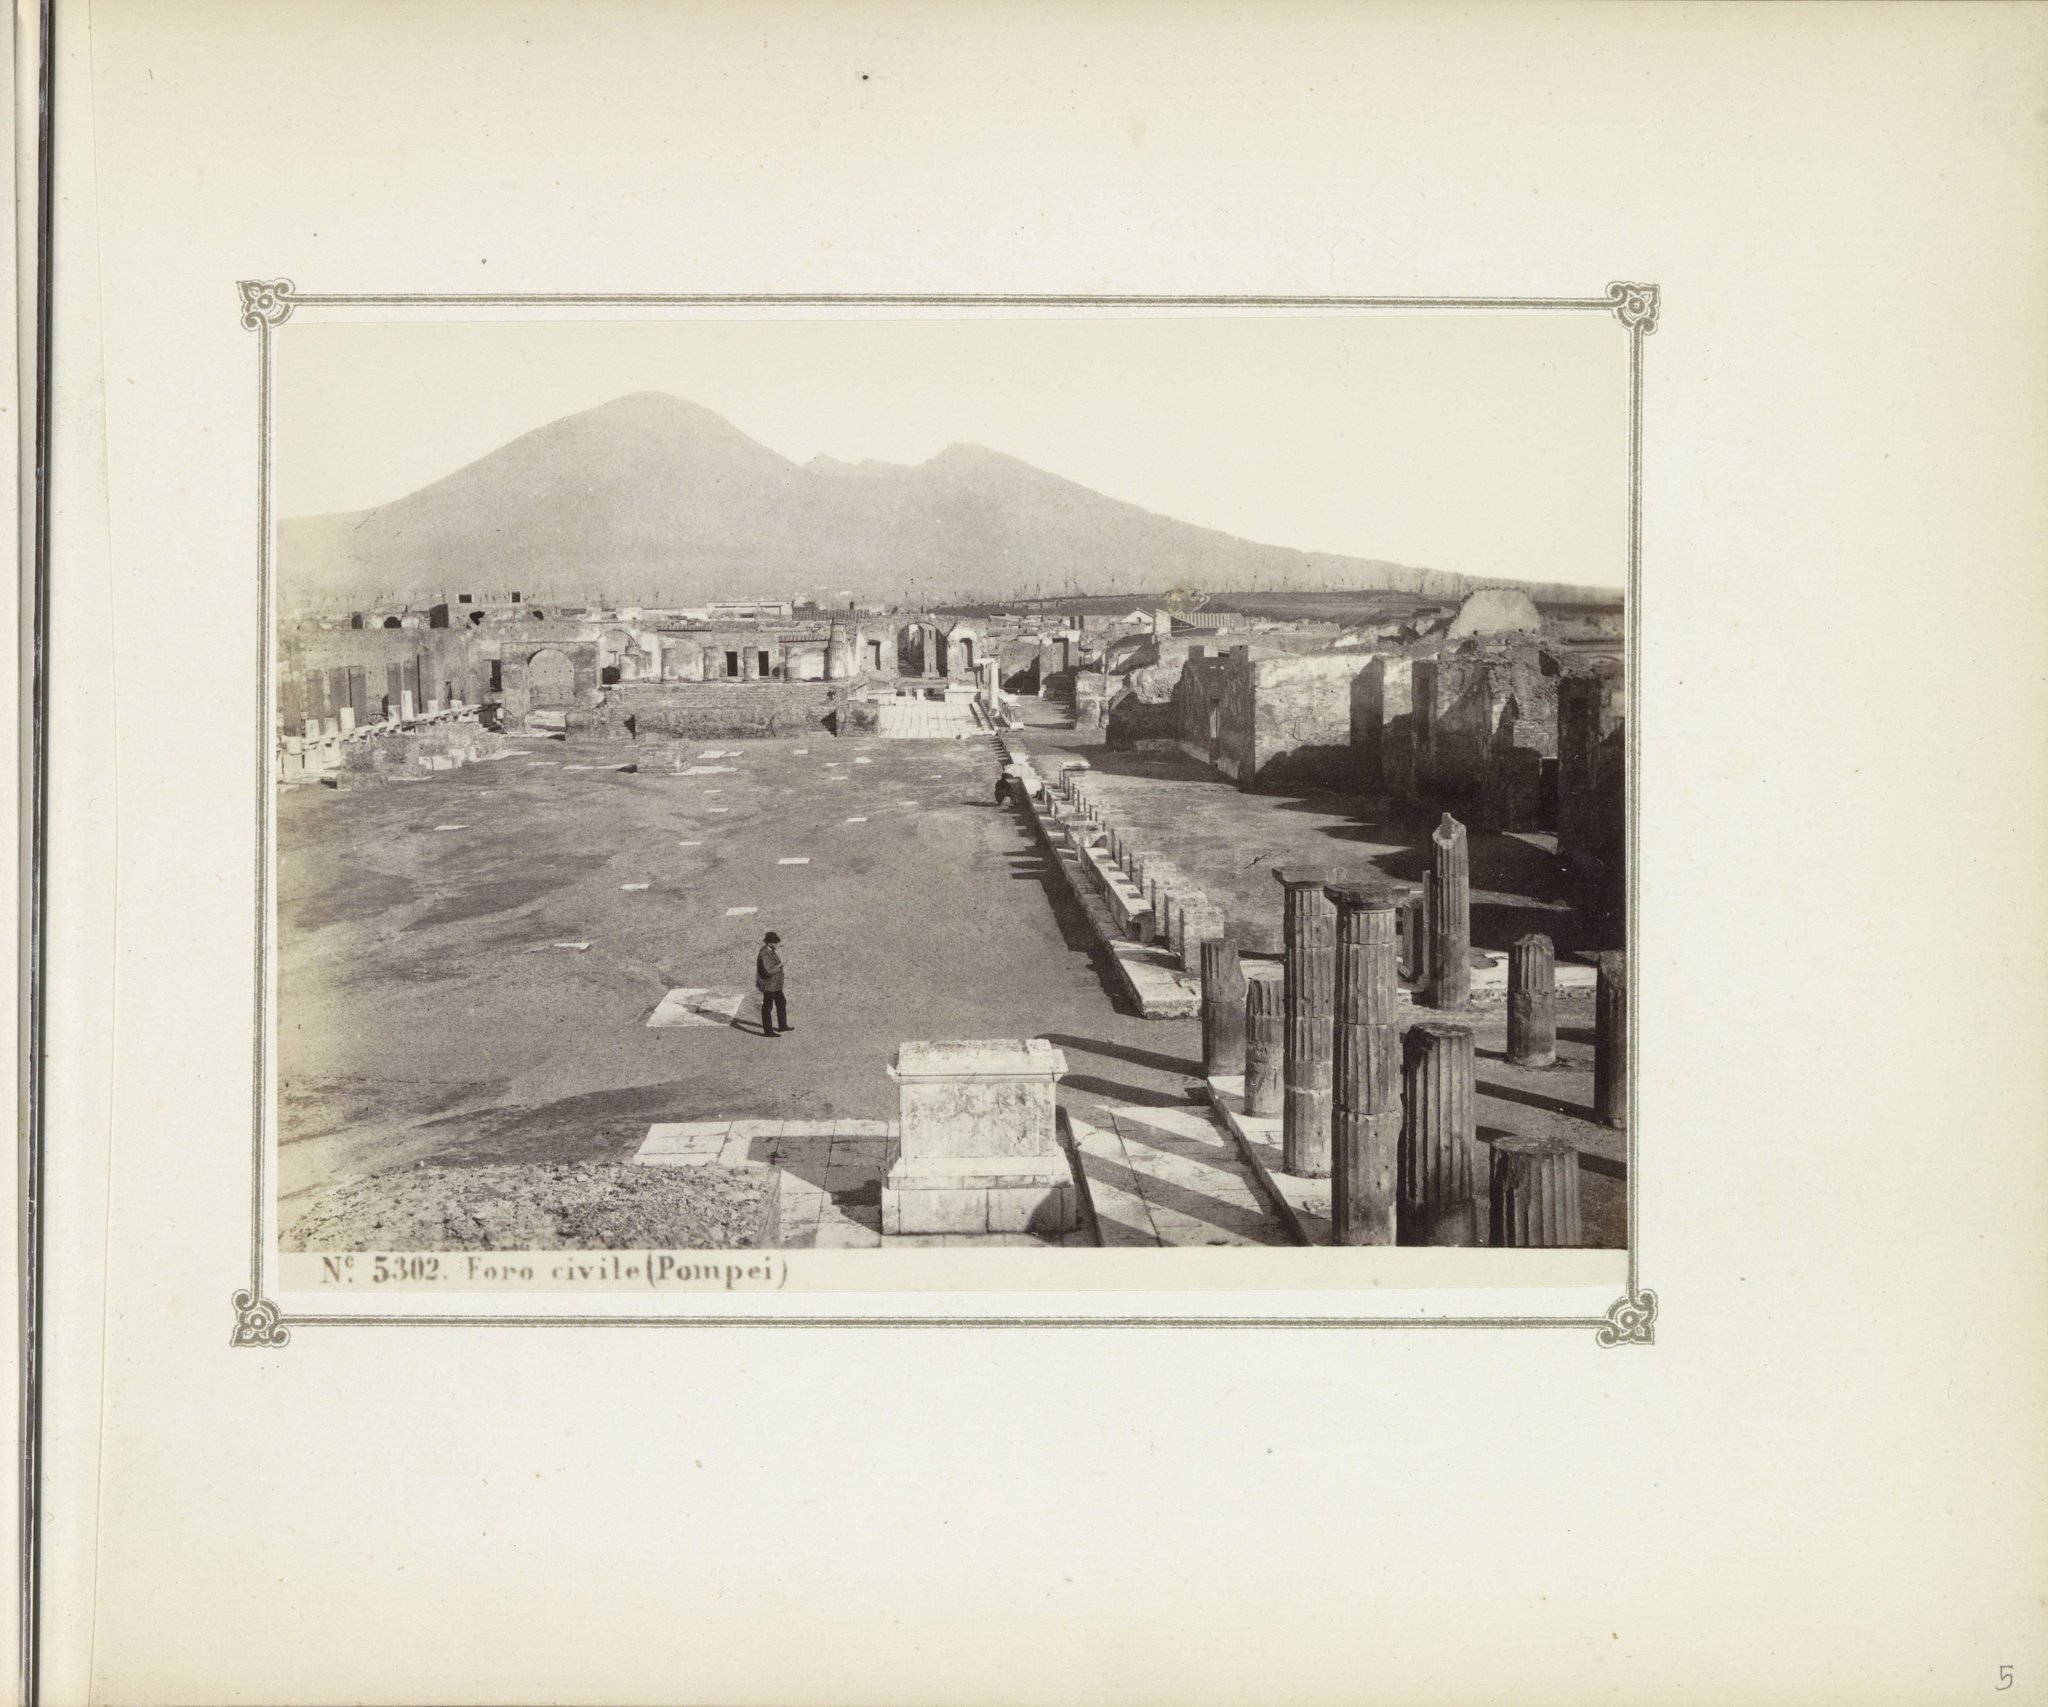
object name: photograph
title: Foro civile. (Pompei.)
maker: giorgio sommer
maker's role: fotograaf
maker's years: 1834-1914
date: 1860-1900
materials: paper, photographic support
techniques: albumen print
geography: pompeii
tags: square, place, circus, etc., excavation ~ archaeology, volcano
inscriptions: number: ‘5302’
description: Onderdeel van Fotoalbum met opnames van opgravingen in Pompeï door Giorgio Sommer.